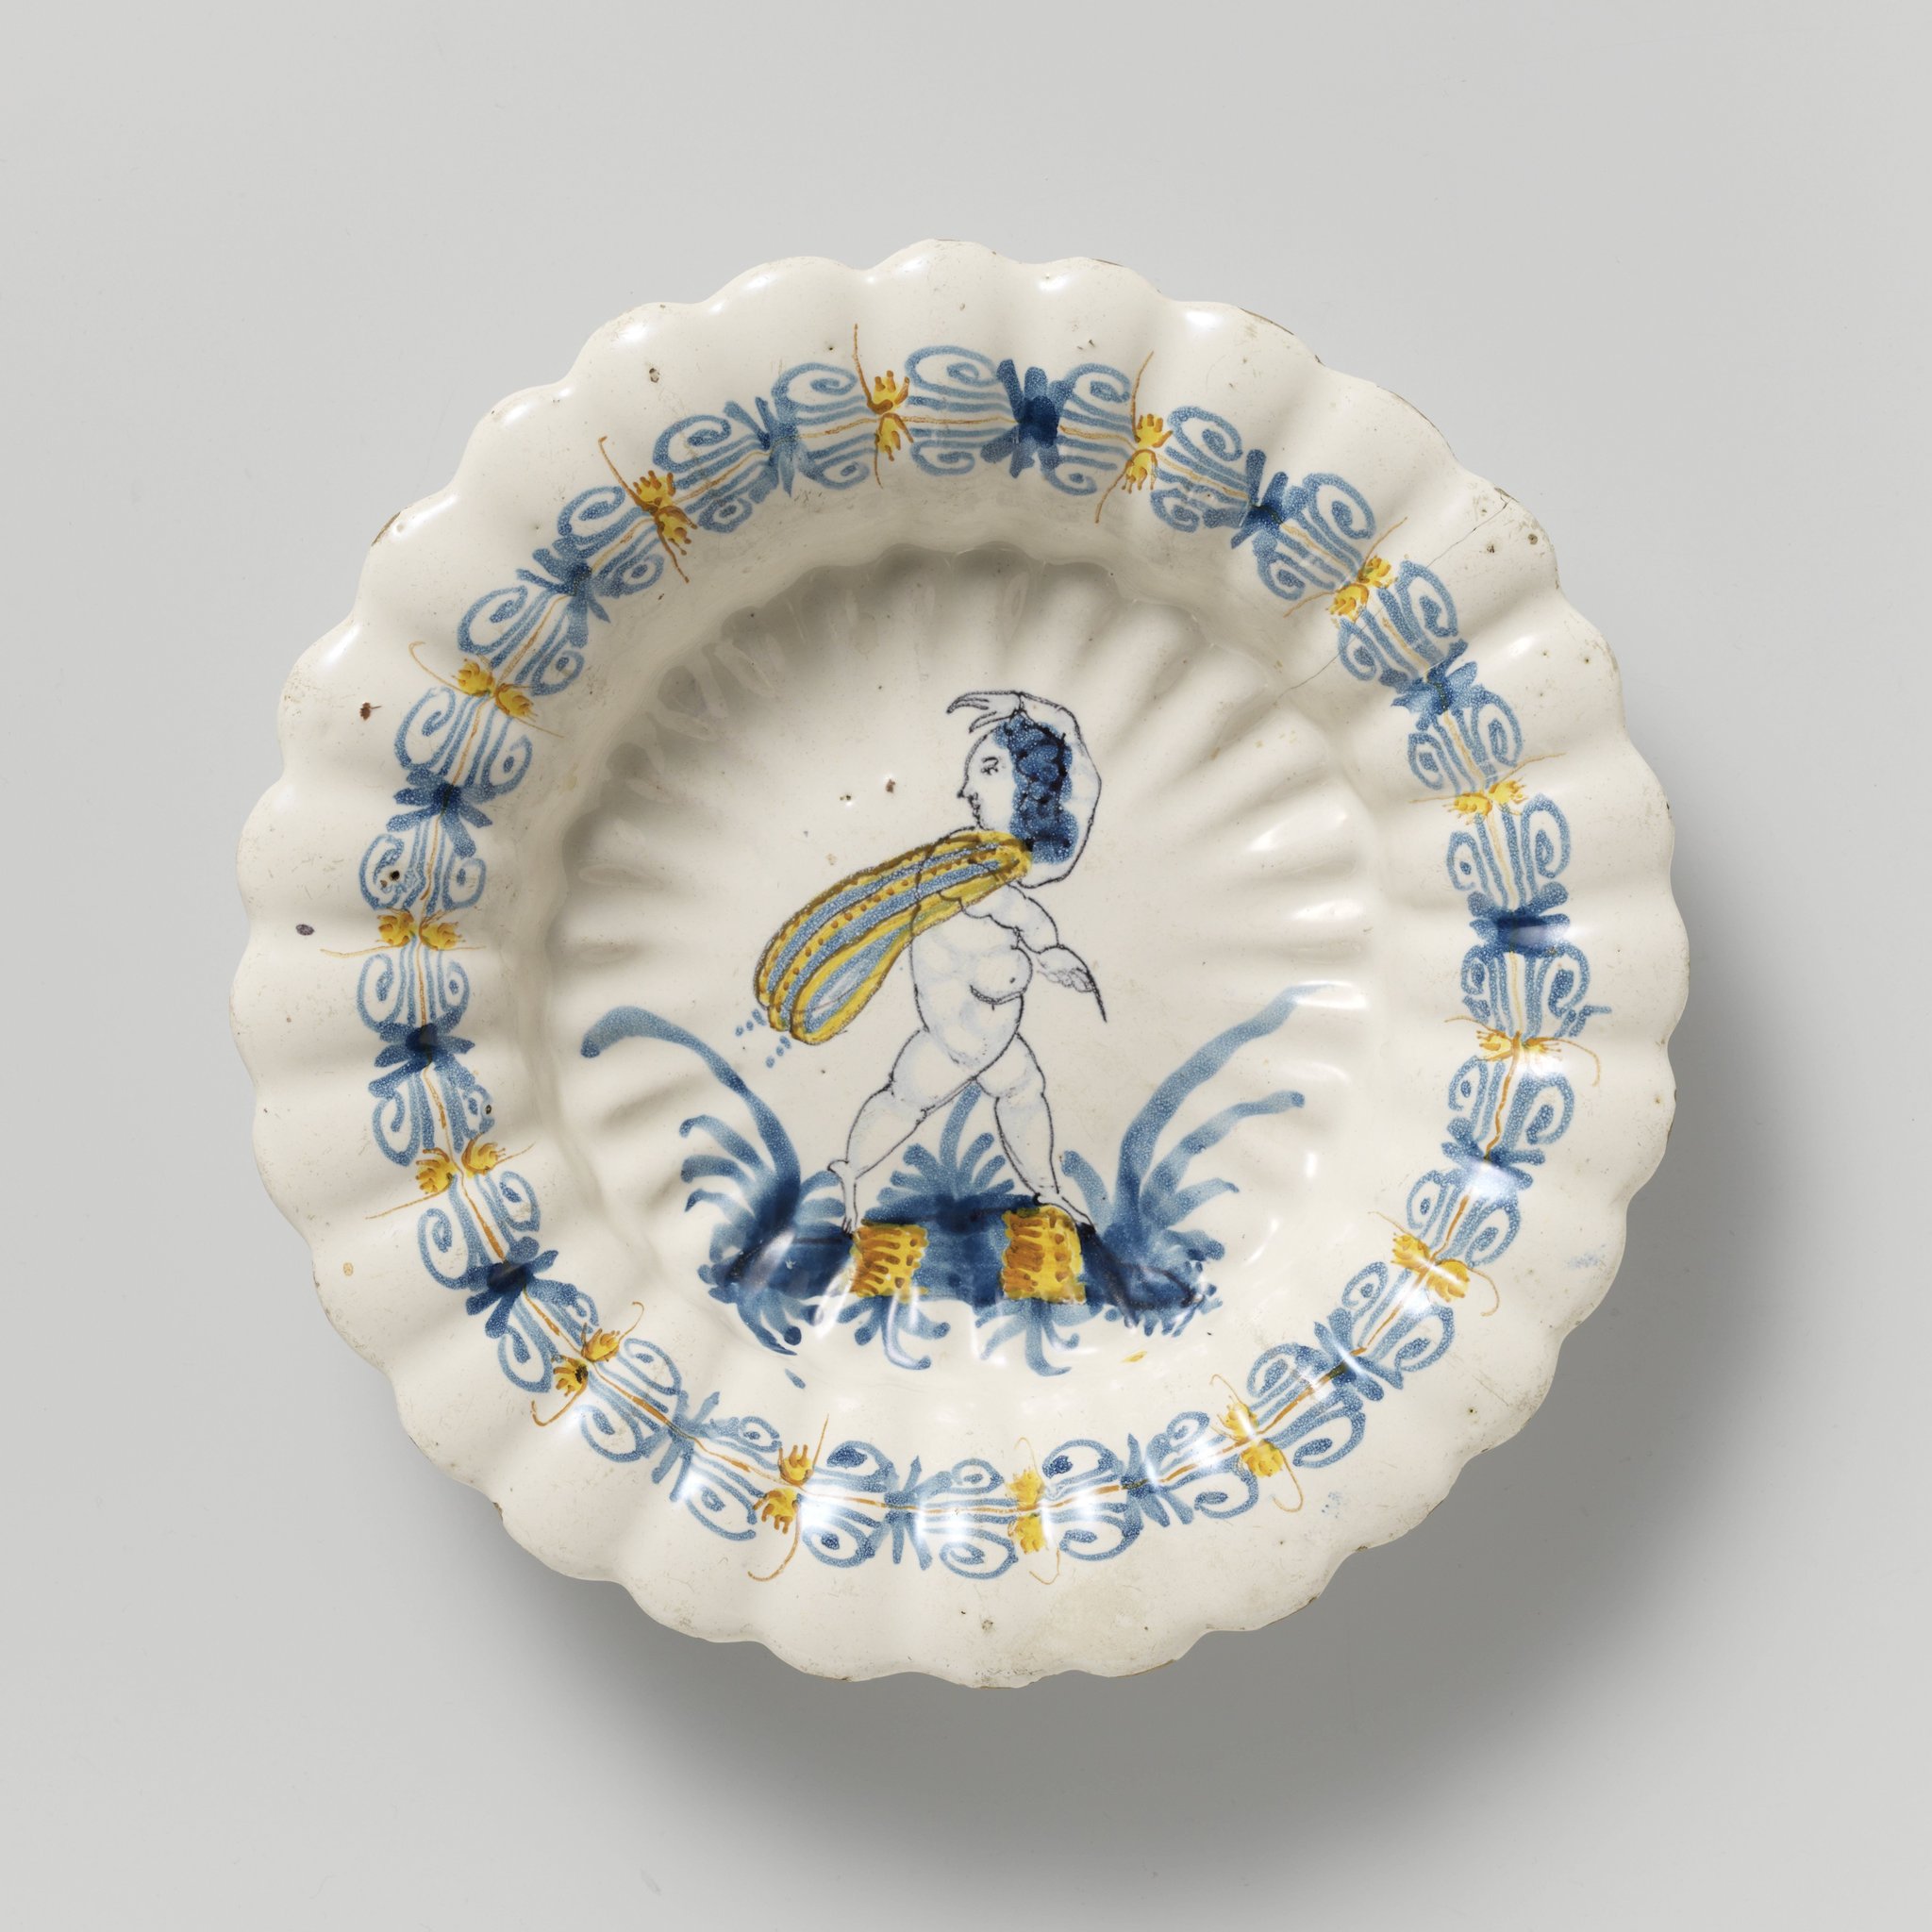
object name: platter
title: plooischotel met in het plat een putto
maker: Anonymous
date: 1650-1675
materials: earthenware, glaze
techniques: painted, polychromy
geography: delft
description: plooischotel van veelkleurig beschilderde faience. De schotel is geschulpt. Op het plat is een putto op een grond geschilderd en op de rand een krans, de gebruikte kleuren zijn blauw, geel, oranje en paars.